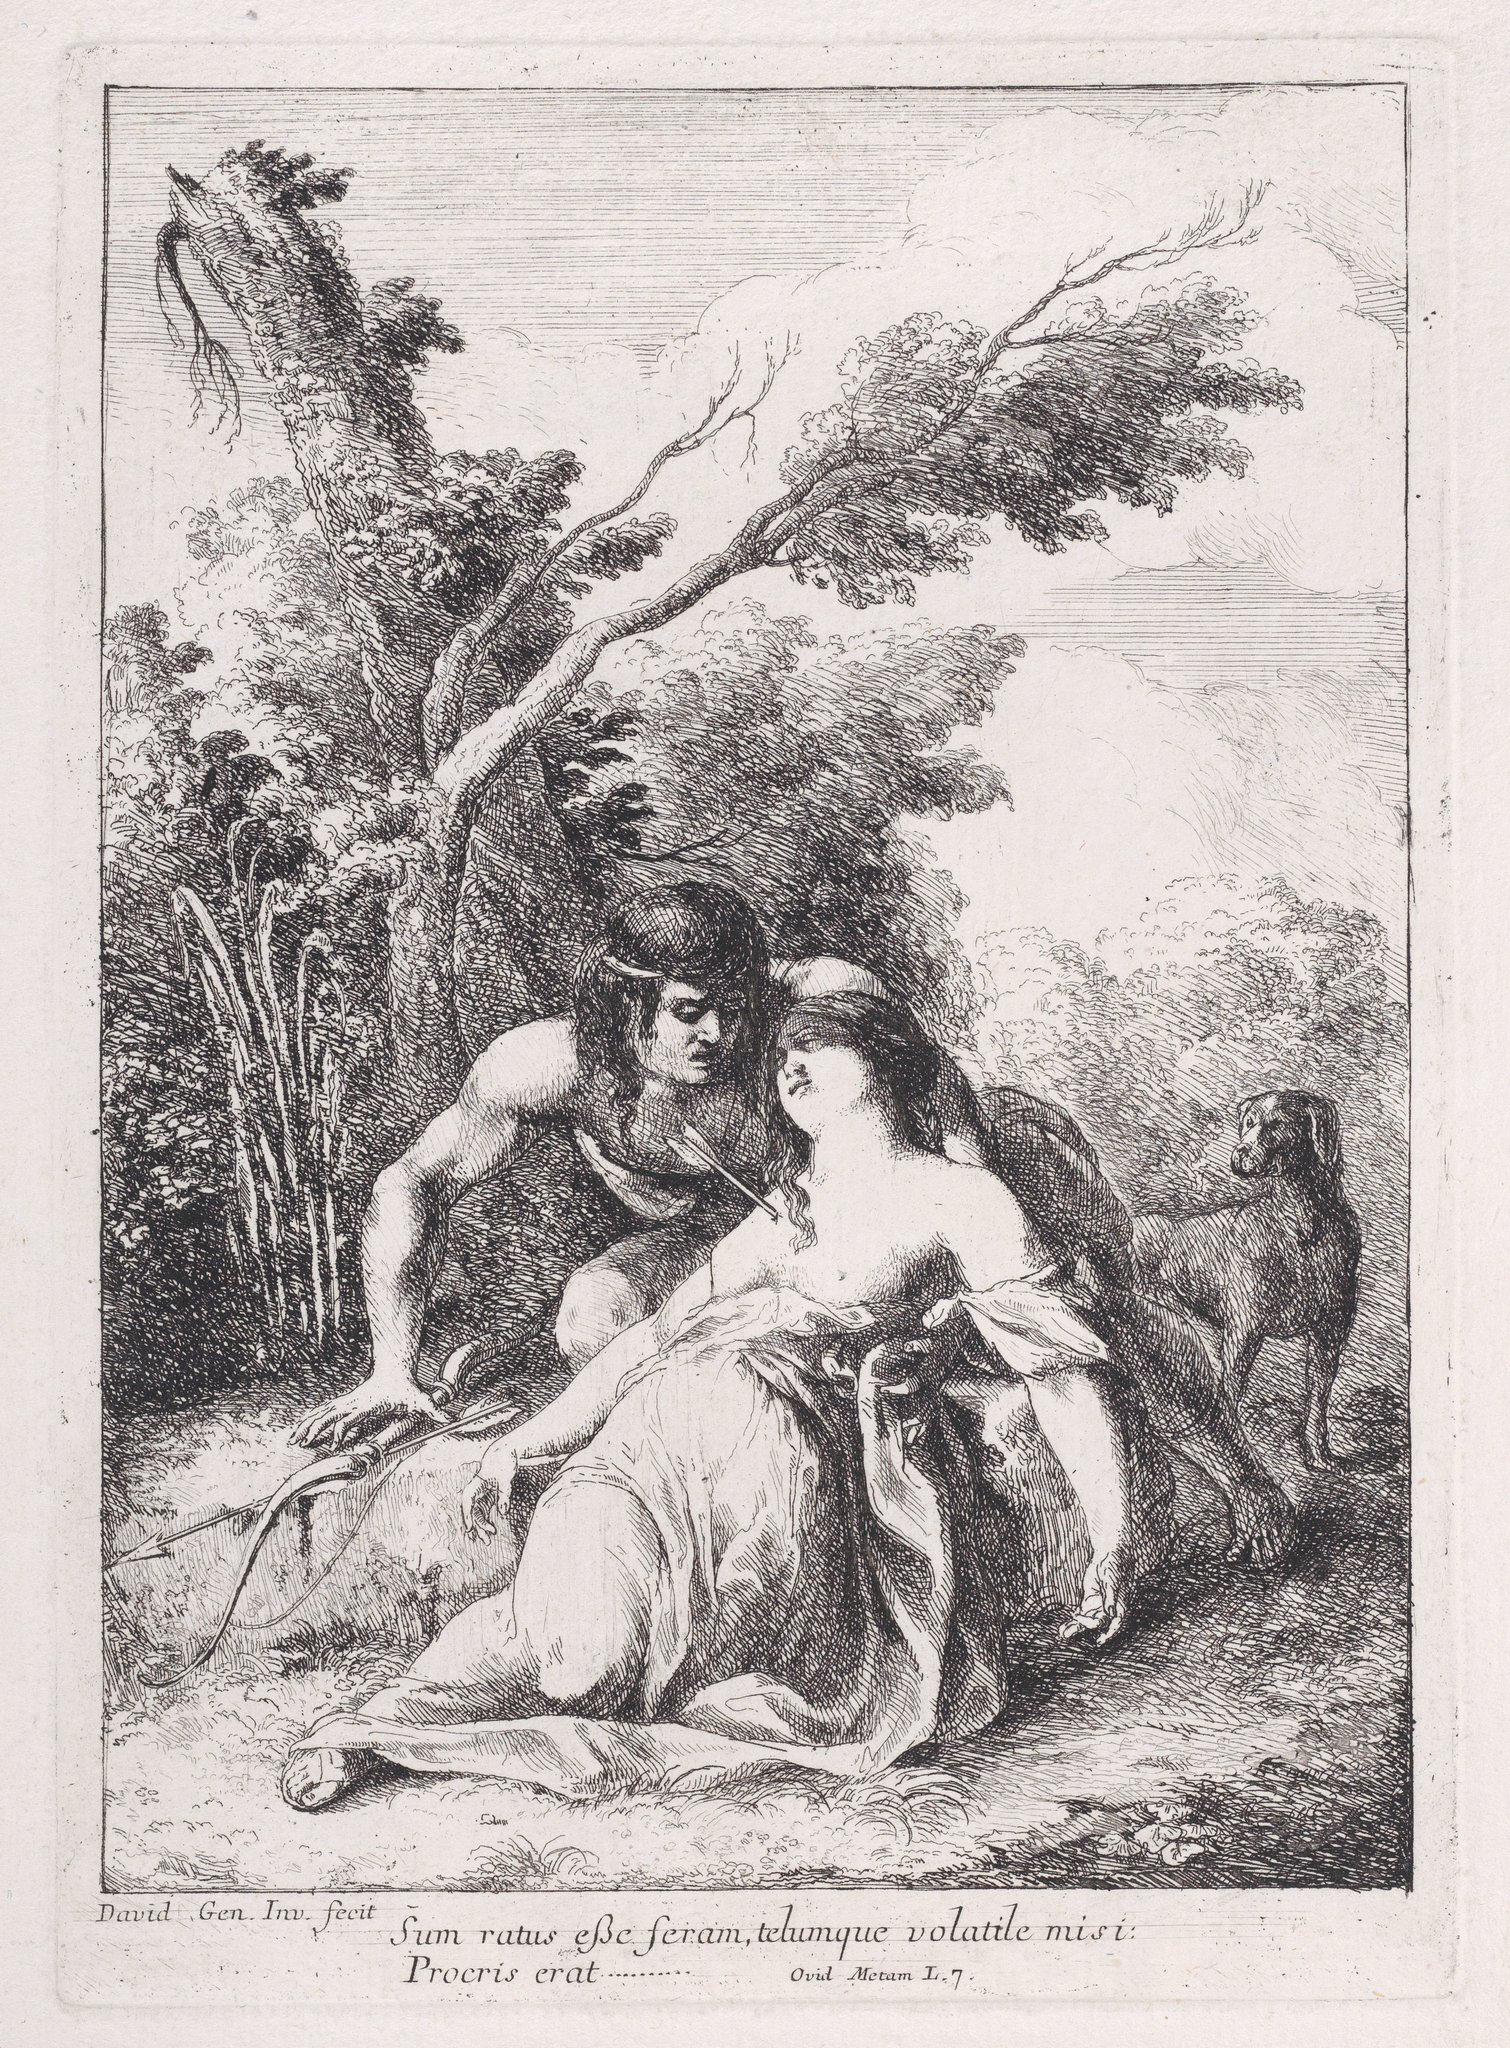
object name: print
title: The Death of Procris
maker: giovanni david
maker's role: artist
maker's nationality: italian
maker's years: 1749-1790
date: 1770-1790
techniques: etching